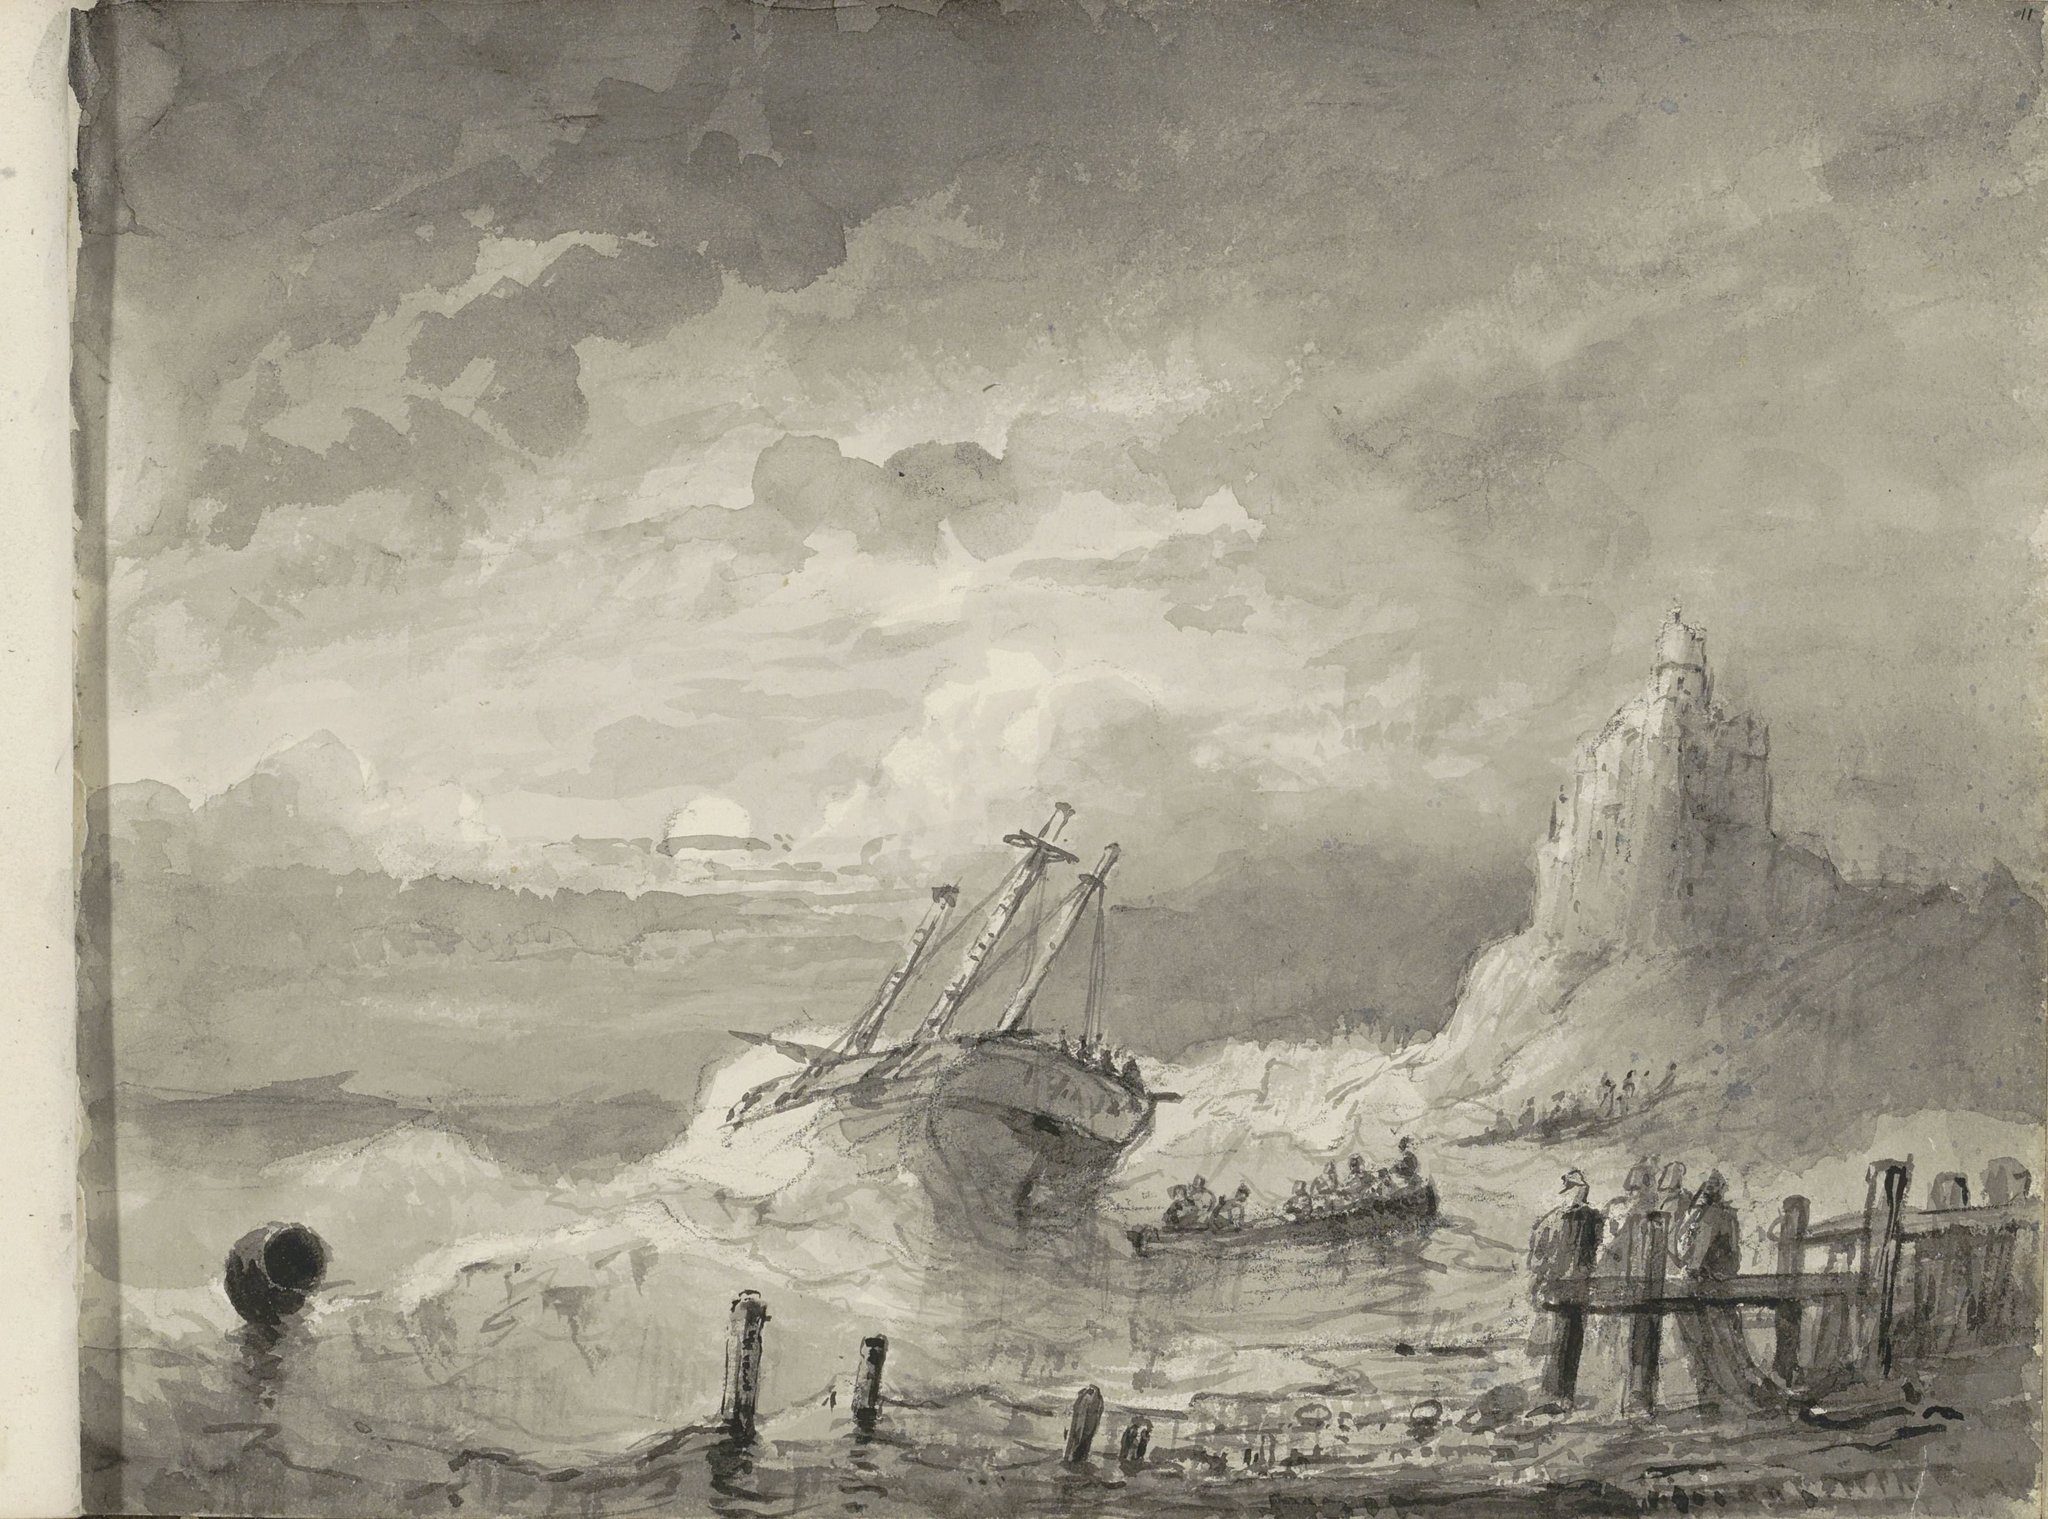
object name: sketchbook leaf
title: Schip in nood voor een kust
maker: petrus johannes schotel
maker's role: draughtsman, painter, print maker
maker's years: 1808-1865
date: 1825-1875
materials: paper, pencil, watercolor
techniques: brush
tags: castle, storm at sea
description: Bij avond of nacht worden op een stormachtige zee mensen met sloepen gered van een schip in nood. Op de achtergrond een kasteel. Blad 11 recto uit een schetsboek met 44 bladen.